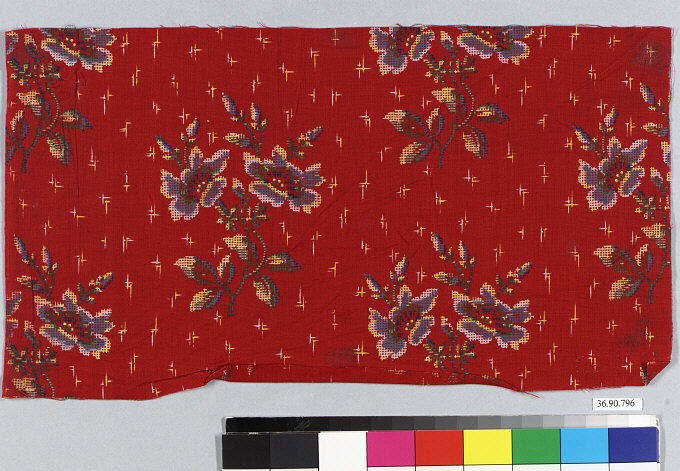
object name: piece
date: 1867-1900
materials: cotton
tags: flowers,leaves